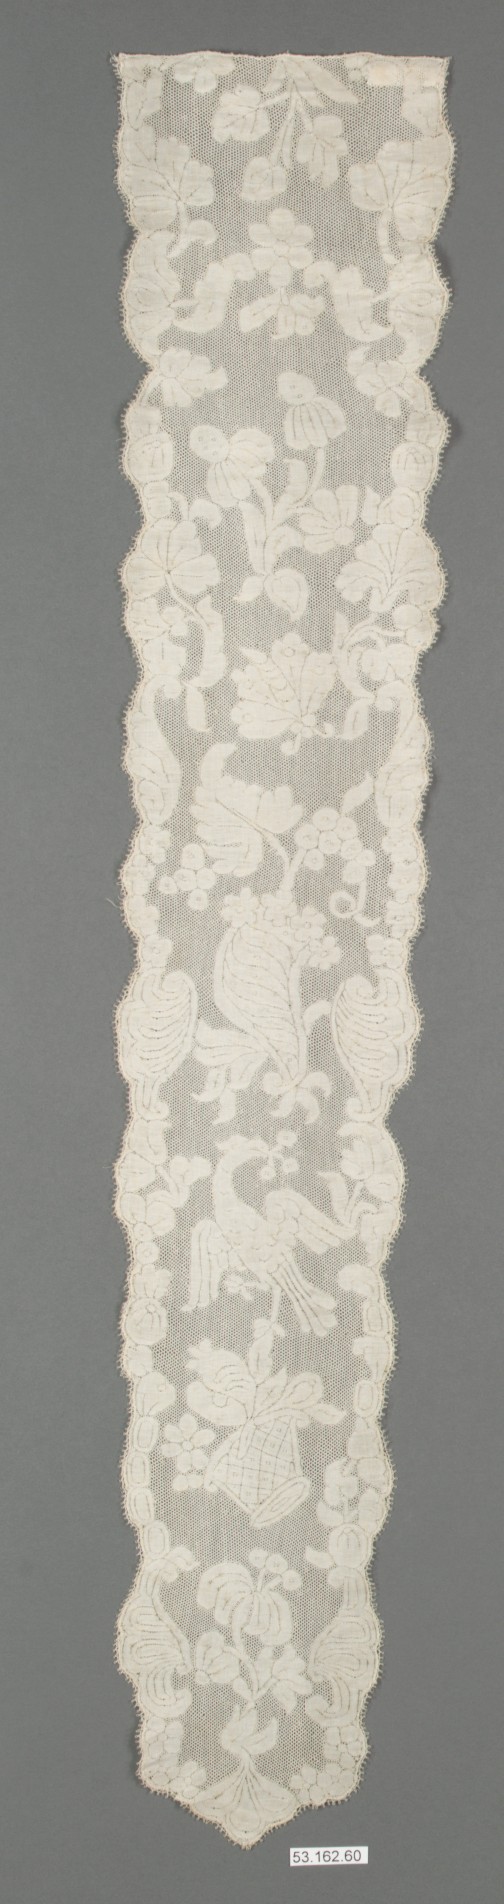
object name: lappet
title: Lappet (one of a pair)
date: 1701-1800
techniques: lace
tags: birds,flowers